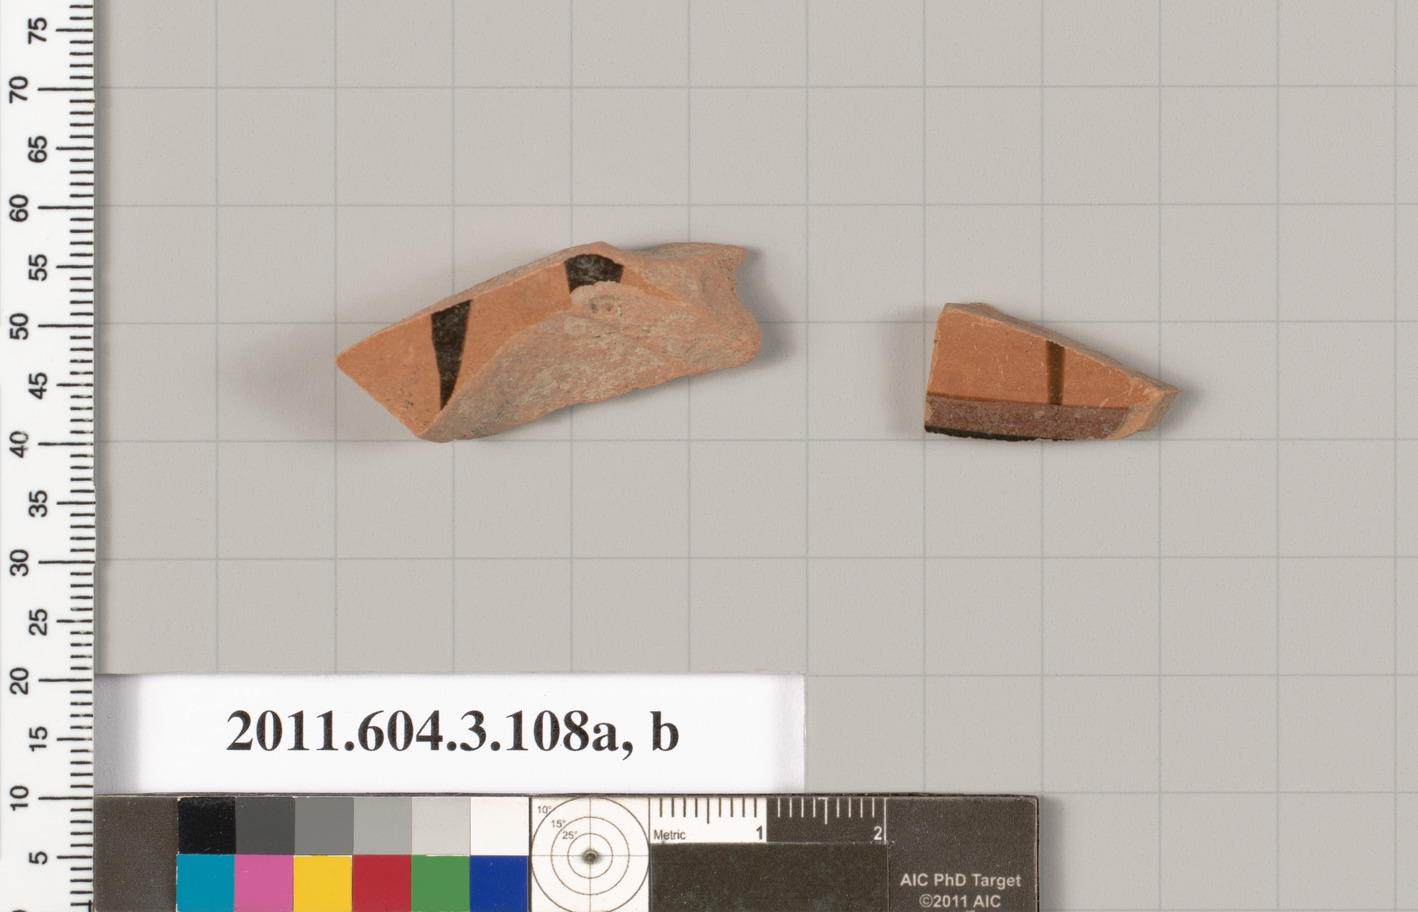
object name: amphora fragment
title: Terracotta fragments of amphorae (jars)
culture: greek, attic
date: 600-468 BCE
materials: terracotta